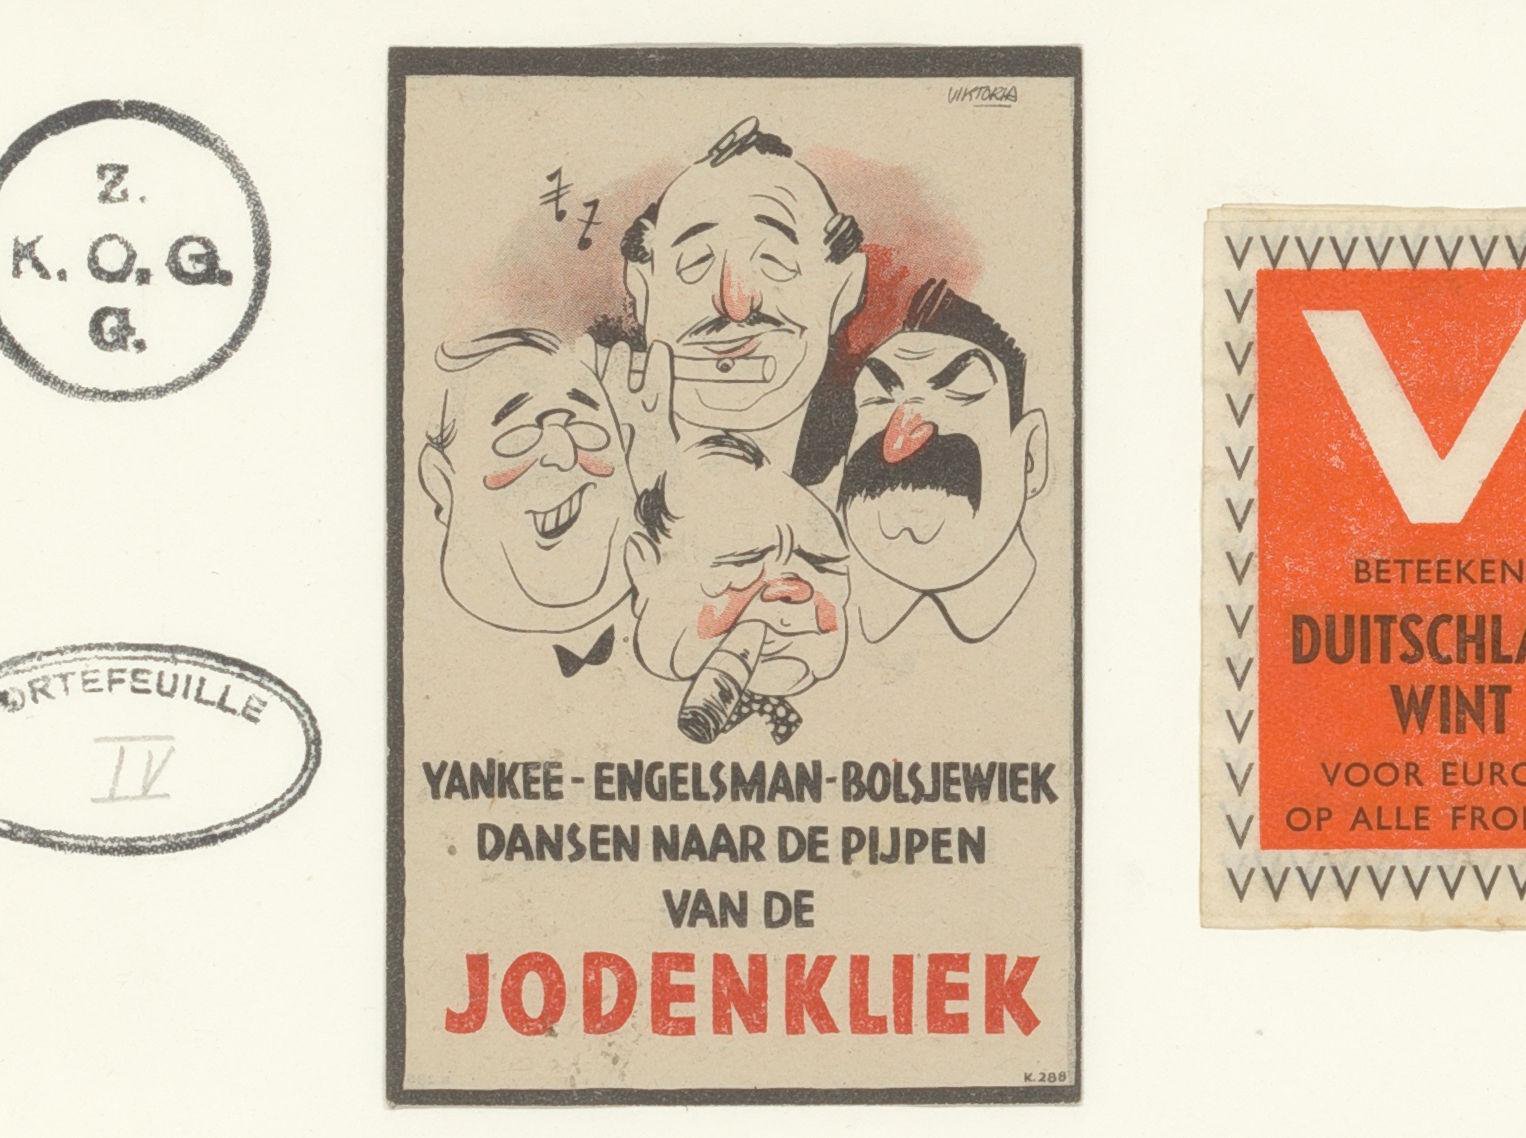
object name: photomechanical print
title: Yankee-Engelsman-Bolsjewiek dansen naar de pijpen van de Jodenkliek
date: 1940-1945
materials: paper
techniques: autotype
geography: netherlands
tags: london, new york (city), anti-semitism, transverse flute, political caricatures and satires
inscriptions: collector's mark: Lugt 1641, collector's mark